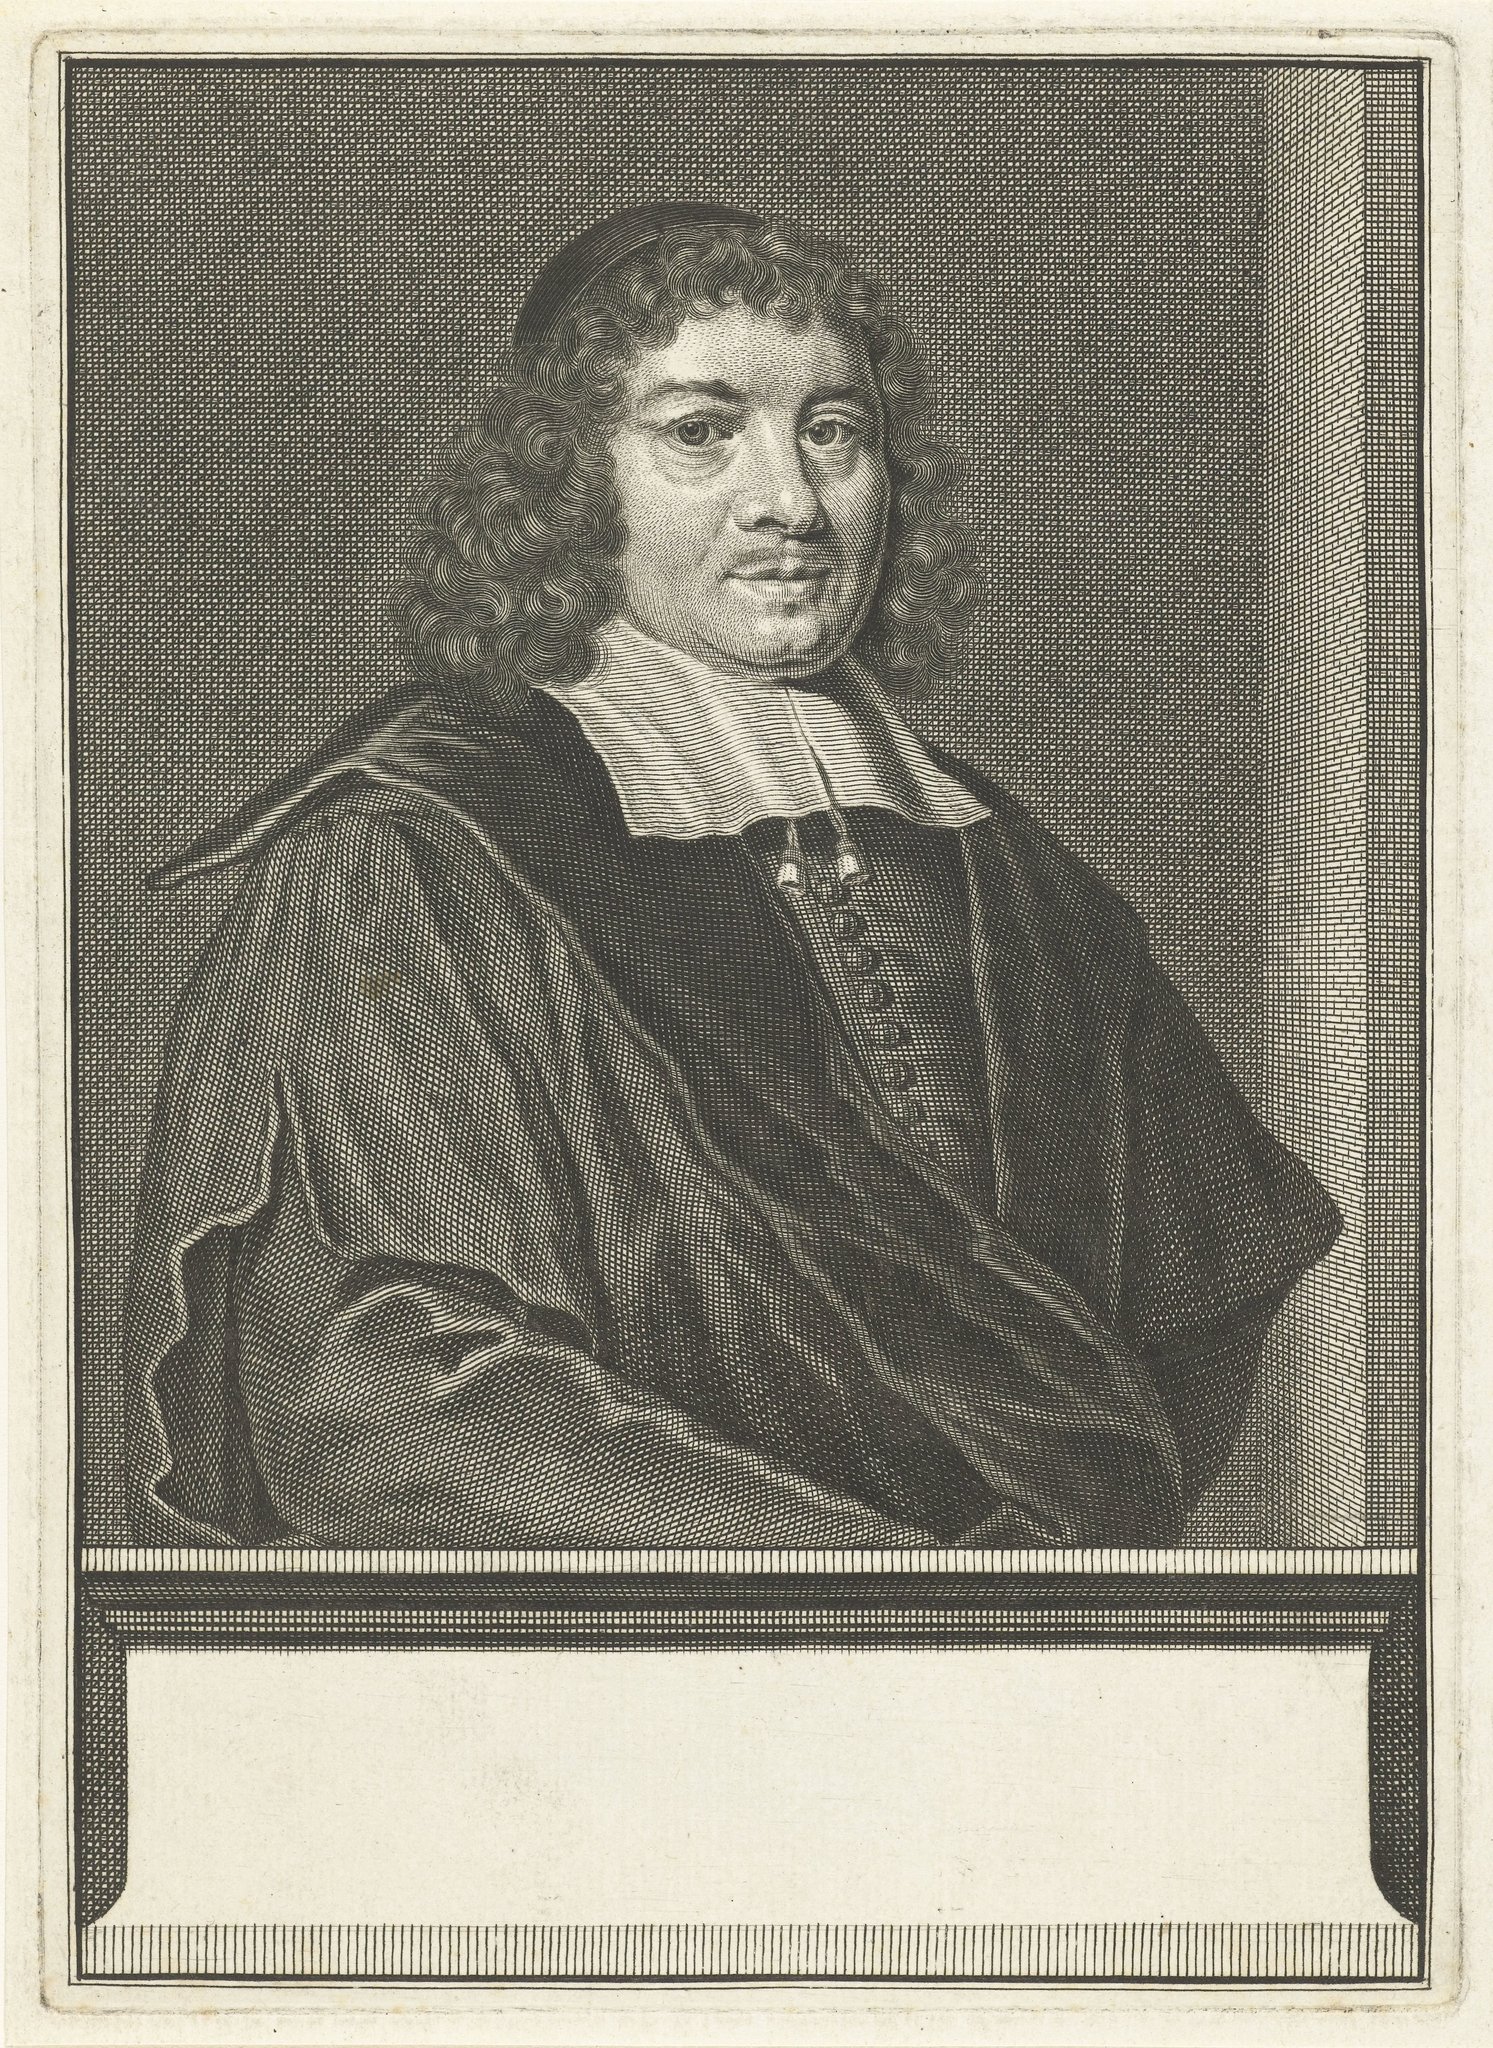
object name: print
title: Portret van Franciscus Burmannus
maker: jacobus baptist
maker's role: print maker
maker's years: 1658-1704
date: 1693-1704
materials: paper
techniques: engraving, etching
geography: amsterdam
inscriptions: collector's mark: Lugt 240